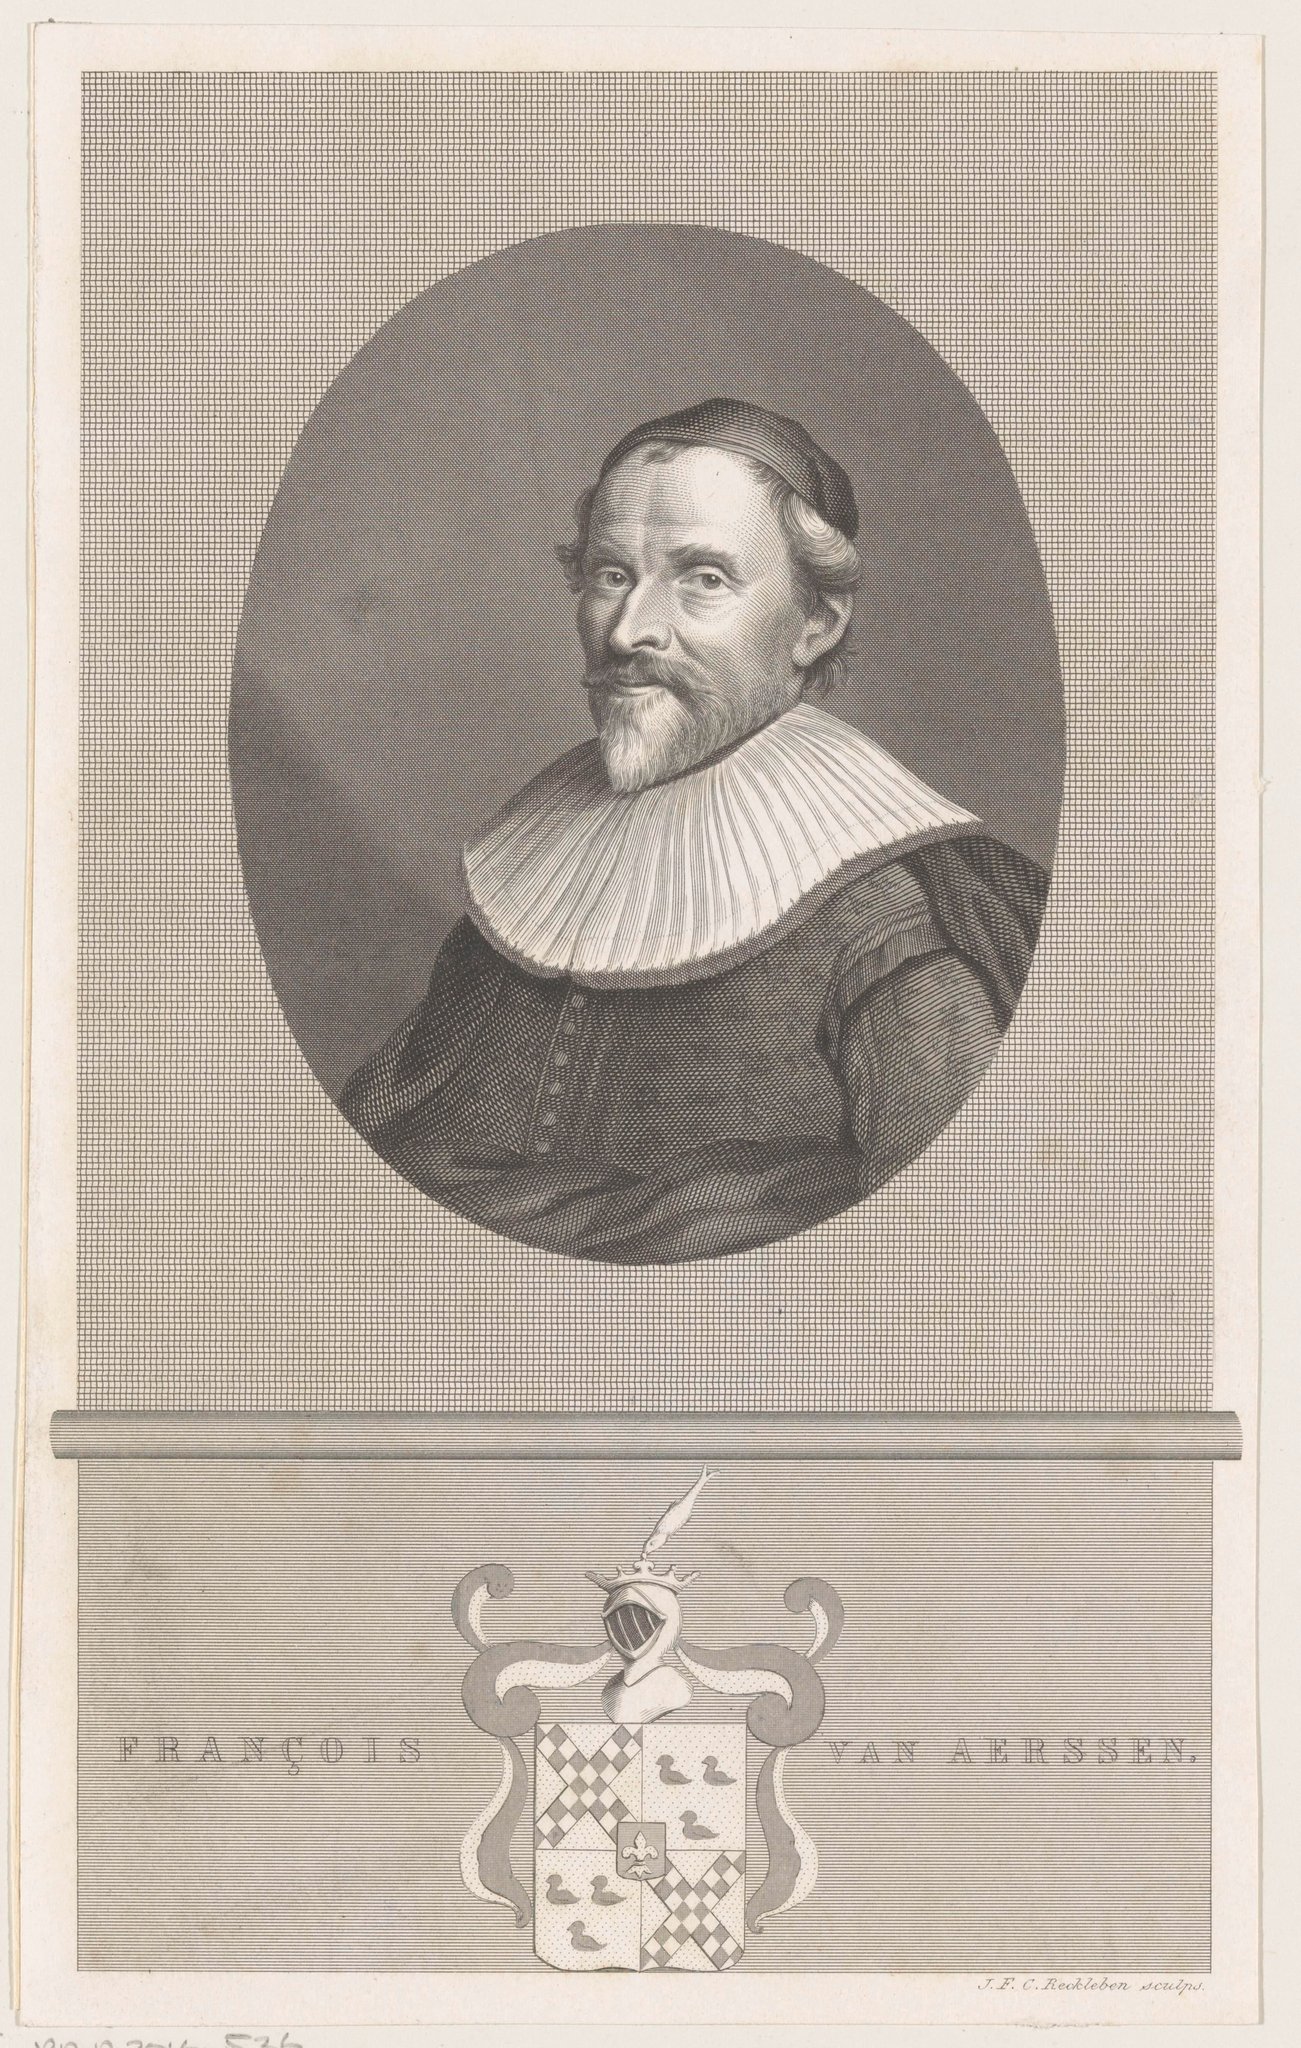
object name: print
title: Portret van François van Aerssen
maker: jan frederik christiaan reckleben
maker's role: print maker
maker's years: 1819-1879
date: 1829-1879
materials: paper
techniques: engraving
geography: amsterdam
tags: brussels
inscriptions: collector's mark: Lugt 2228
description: Portret van François van Aerssen in een ovale omlijsting. Midden onder zijn wapen met een helm. In een kader zijn naam.